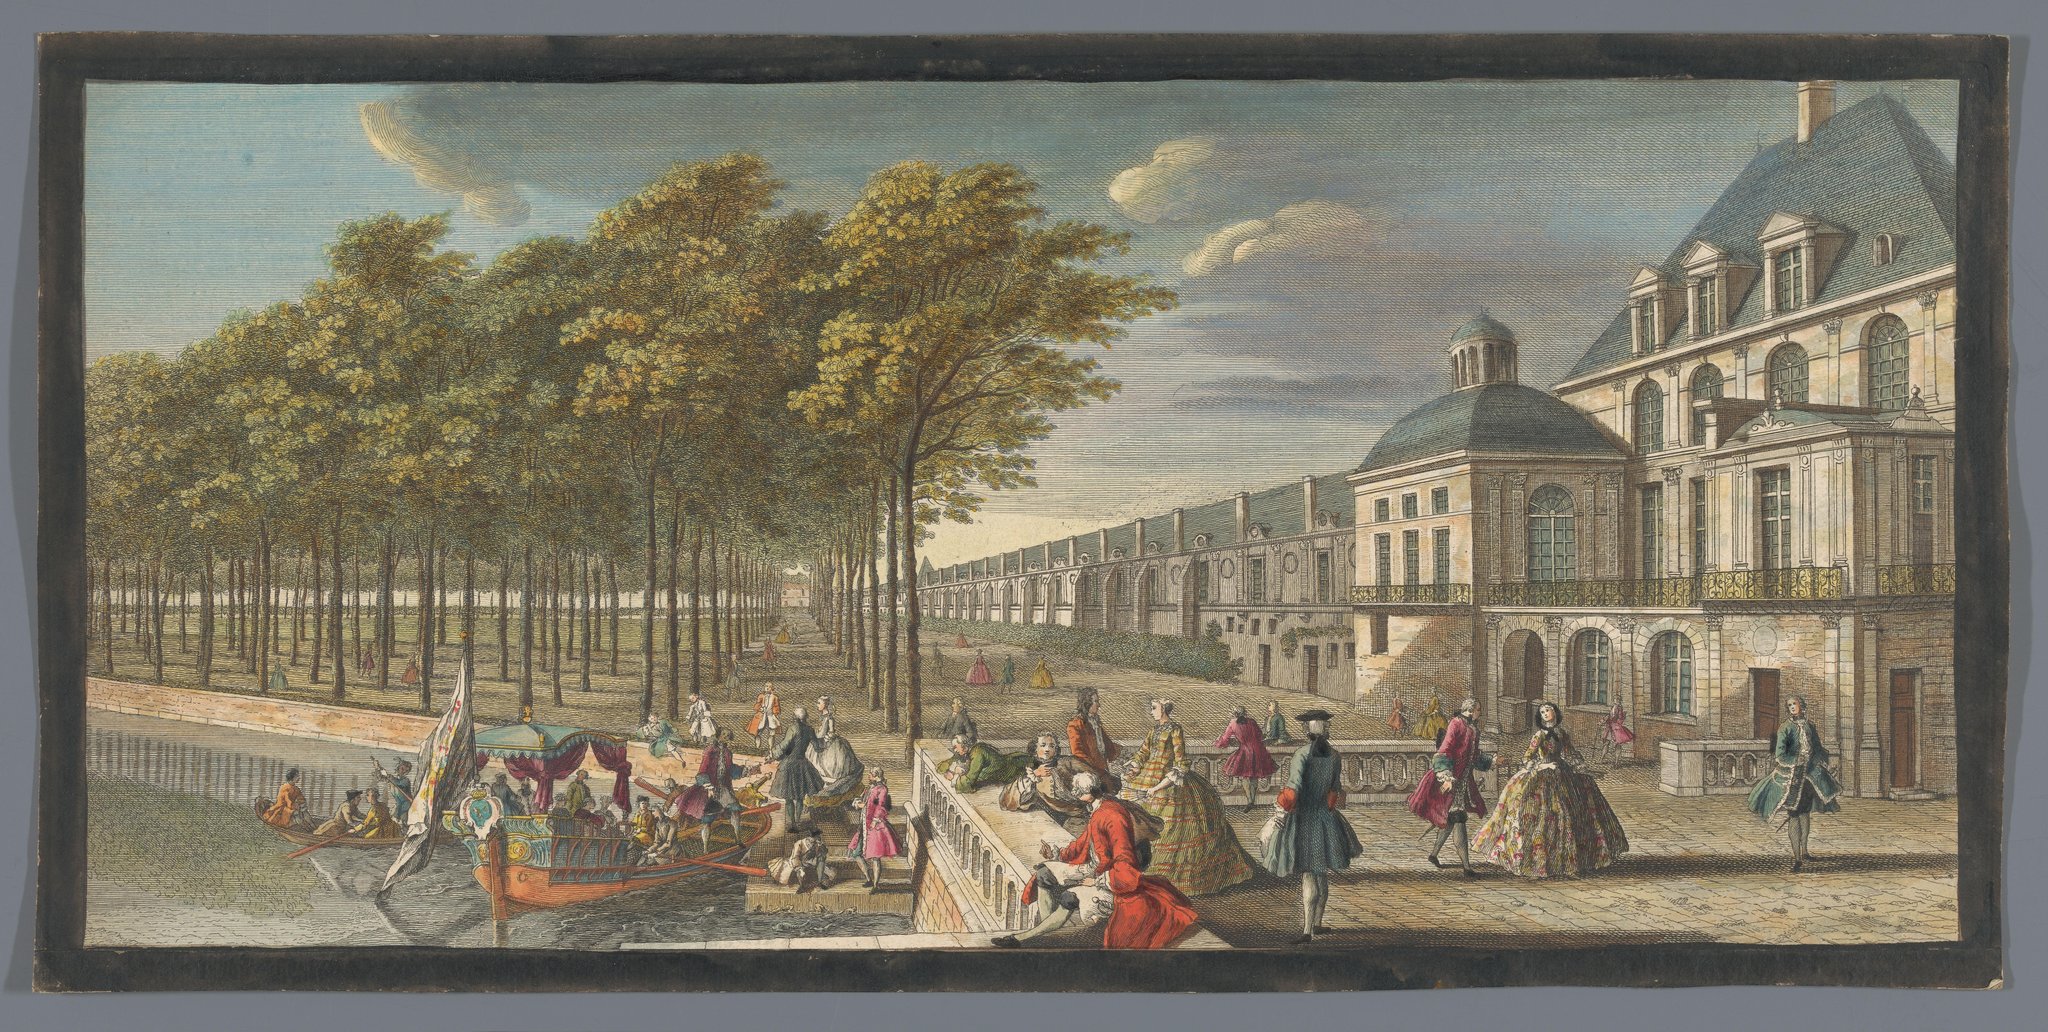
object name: opticaprent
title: A view of one of the wings of Fontainebleau taken from the Court of Fountains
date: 1745-1753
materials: cardboard, paper, watercolor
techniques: brush, etching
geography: england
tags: palace, rowing-boat, canoe, etc., inner court of palace or 'hôtel'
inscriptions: inscription: ‘Fo 13 B4’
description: De serie “Franse paleizen en tuinen” bevat acht prenten met de nummers 1-8, waarvan dit mogelijk nummer 6 is.